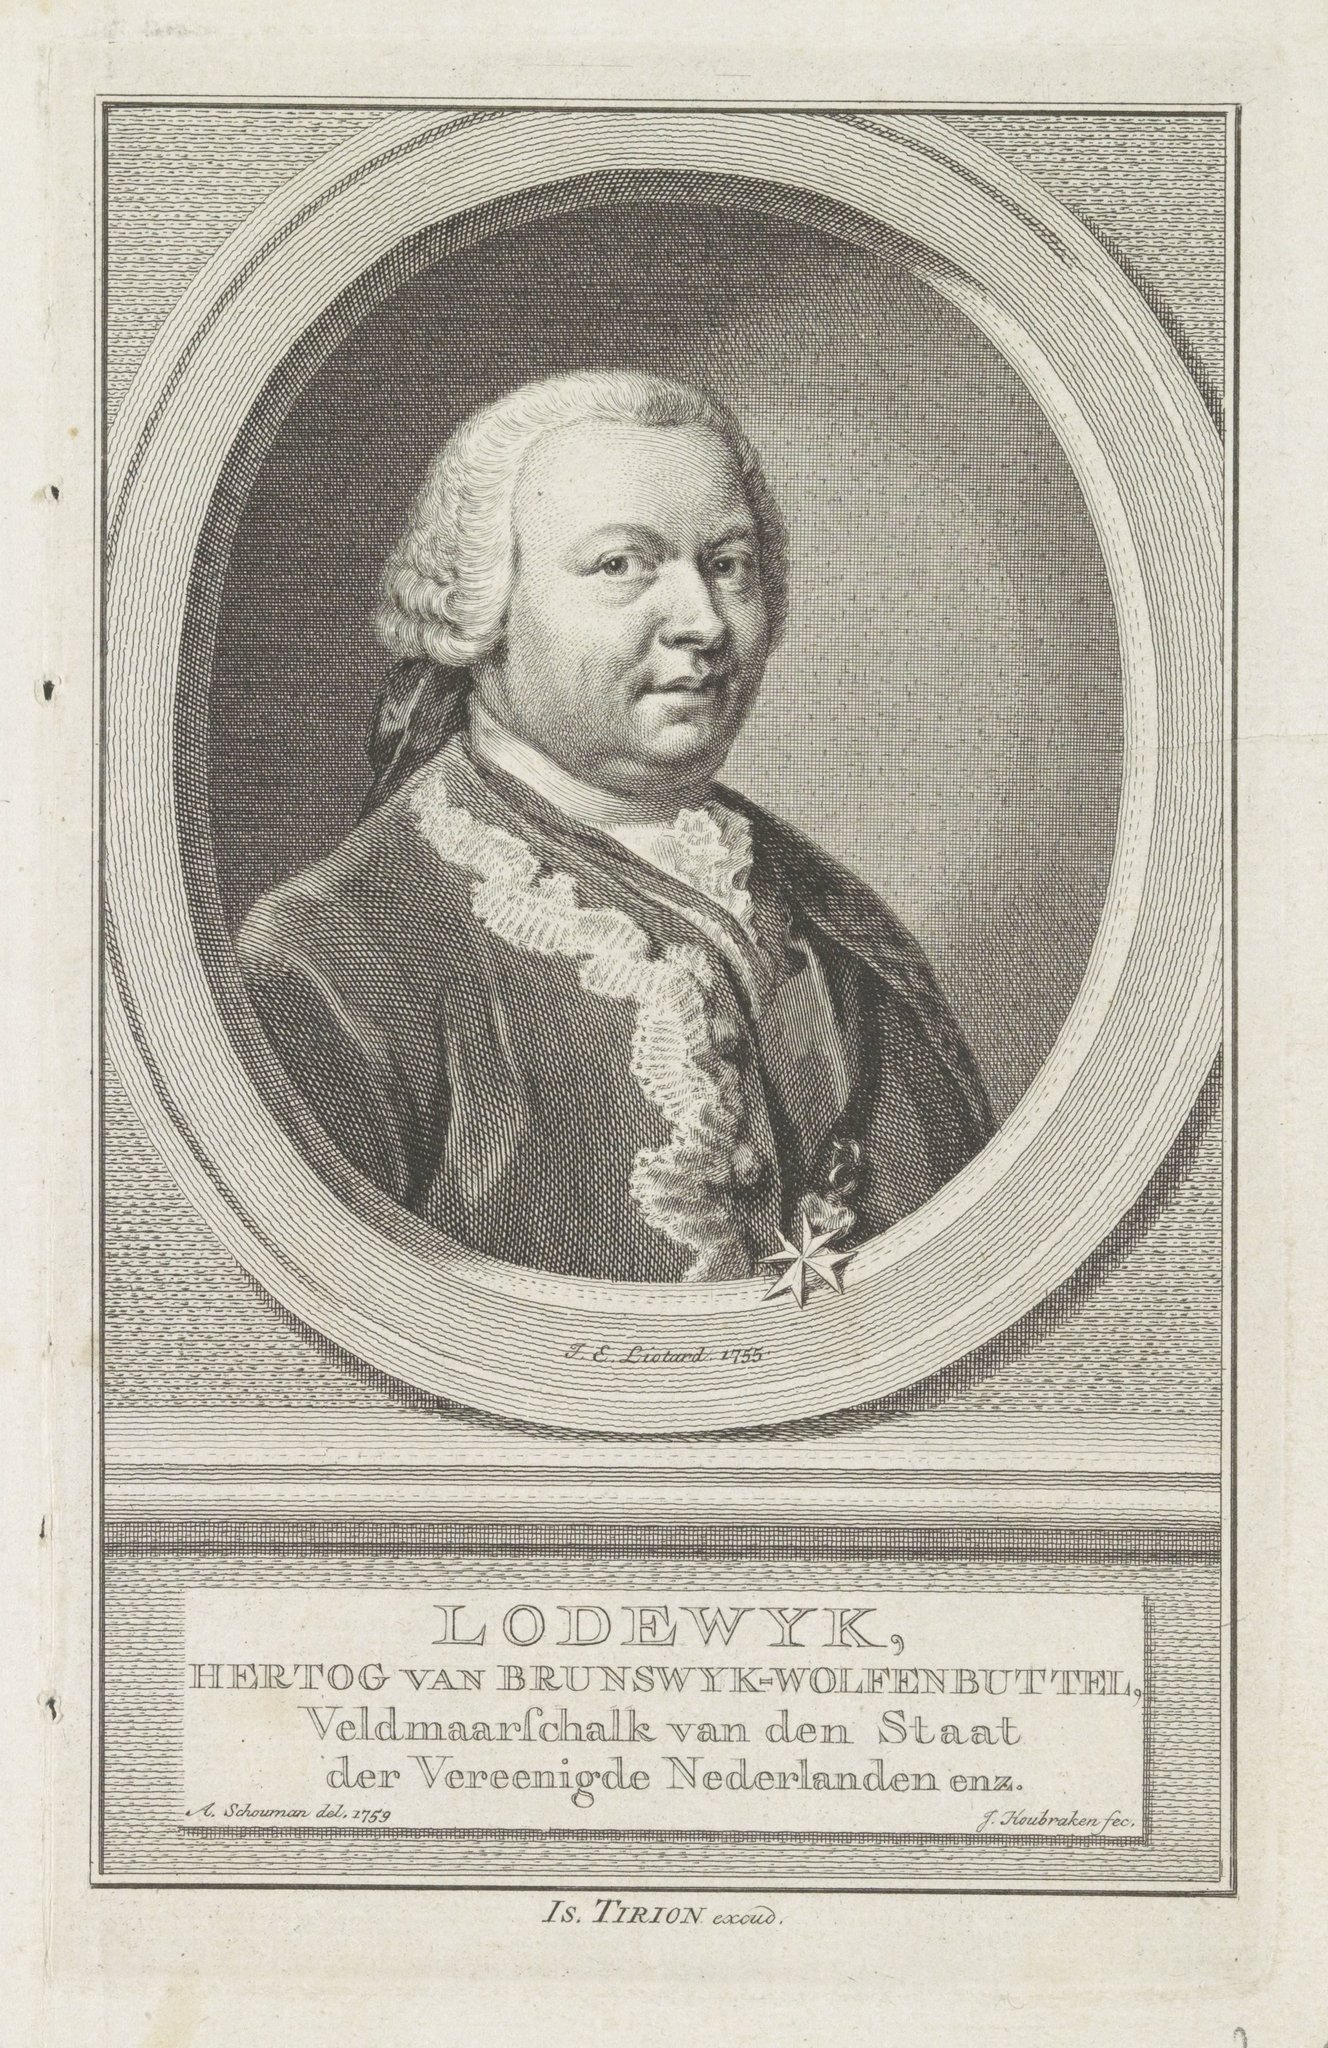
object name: book illustration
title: Portret van Lodewijk van Brunswijk-Wolfenbüttel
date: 1749-1759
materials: paper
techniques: engraving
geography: amsterdam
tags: ludwig ernst von braunschweig-wolfenbüttel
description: De hier vermelde titel verwijst naar de hoogst verkregen titel van de geportretteerde, niet per se naar de titel die de geportretteerde op deze voorstelling draagt. Prent uit: Wagenaar, Jan. Vaderlandsche historie. Amsterdam: Isaak Tirion, 1749-1759.